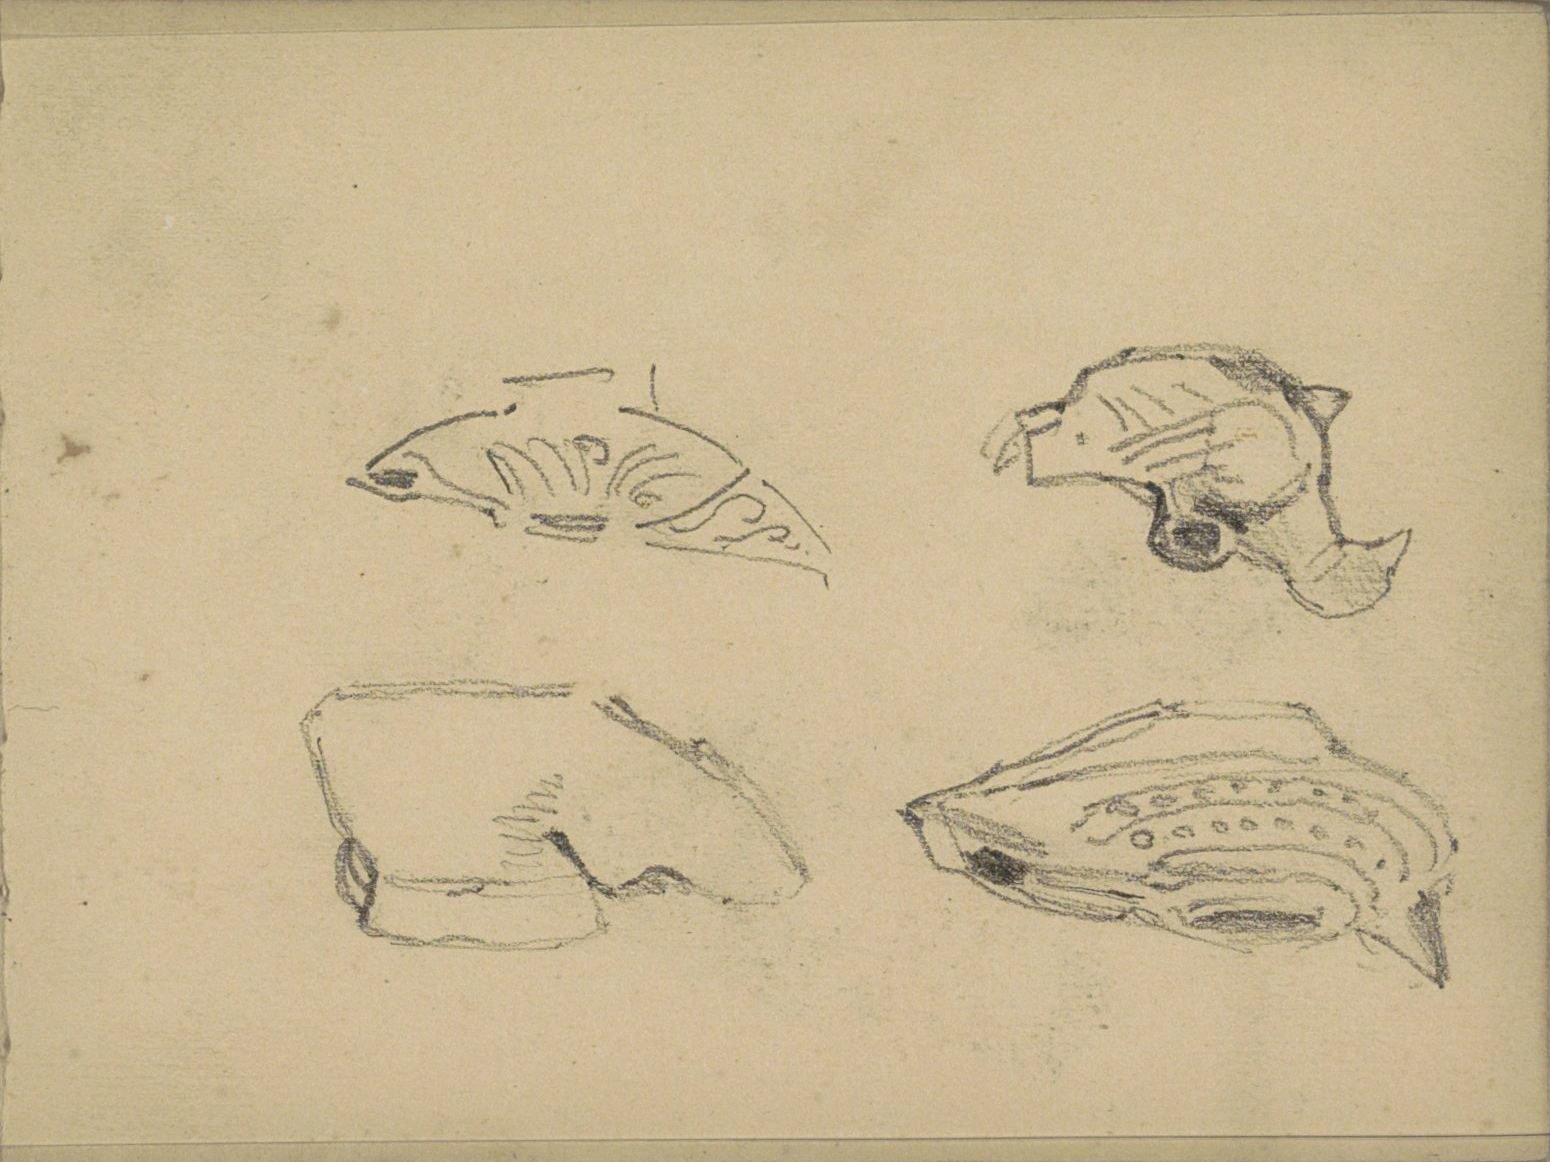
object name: sketchbook leaf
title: Archeologische overblijfselen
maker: george clausen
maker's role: draughtsman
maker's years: 1852-1912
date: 1874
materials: paper, pencil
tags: oil-lamp, sculpture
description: Vermoedelijk een olielampen of stukken van beeldhouwwerk. Blad 16 recto uit een schetsboek met 37 bladen.